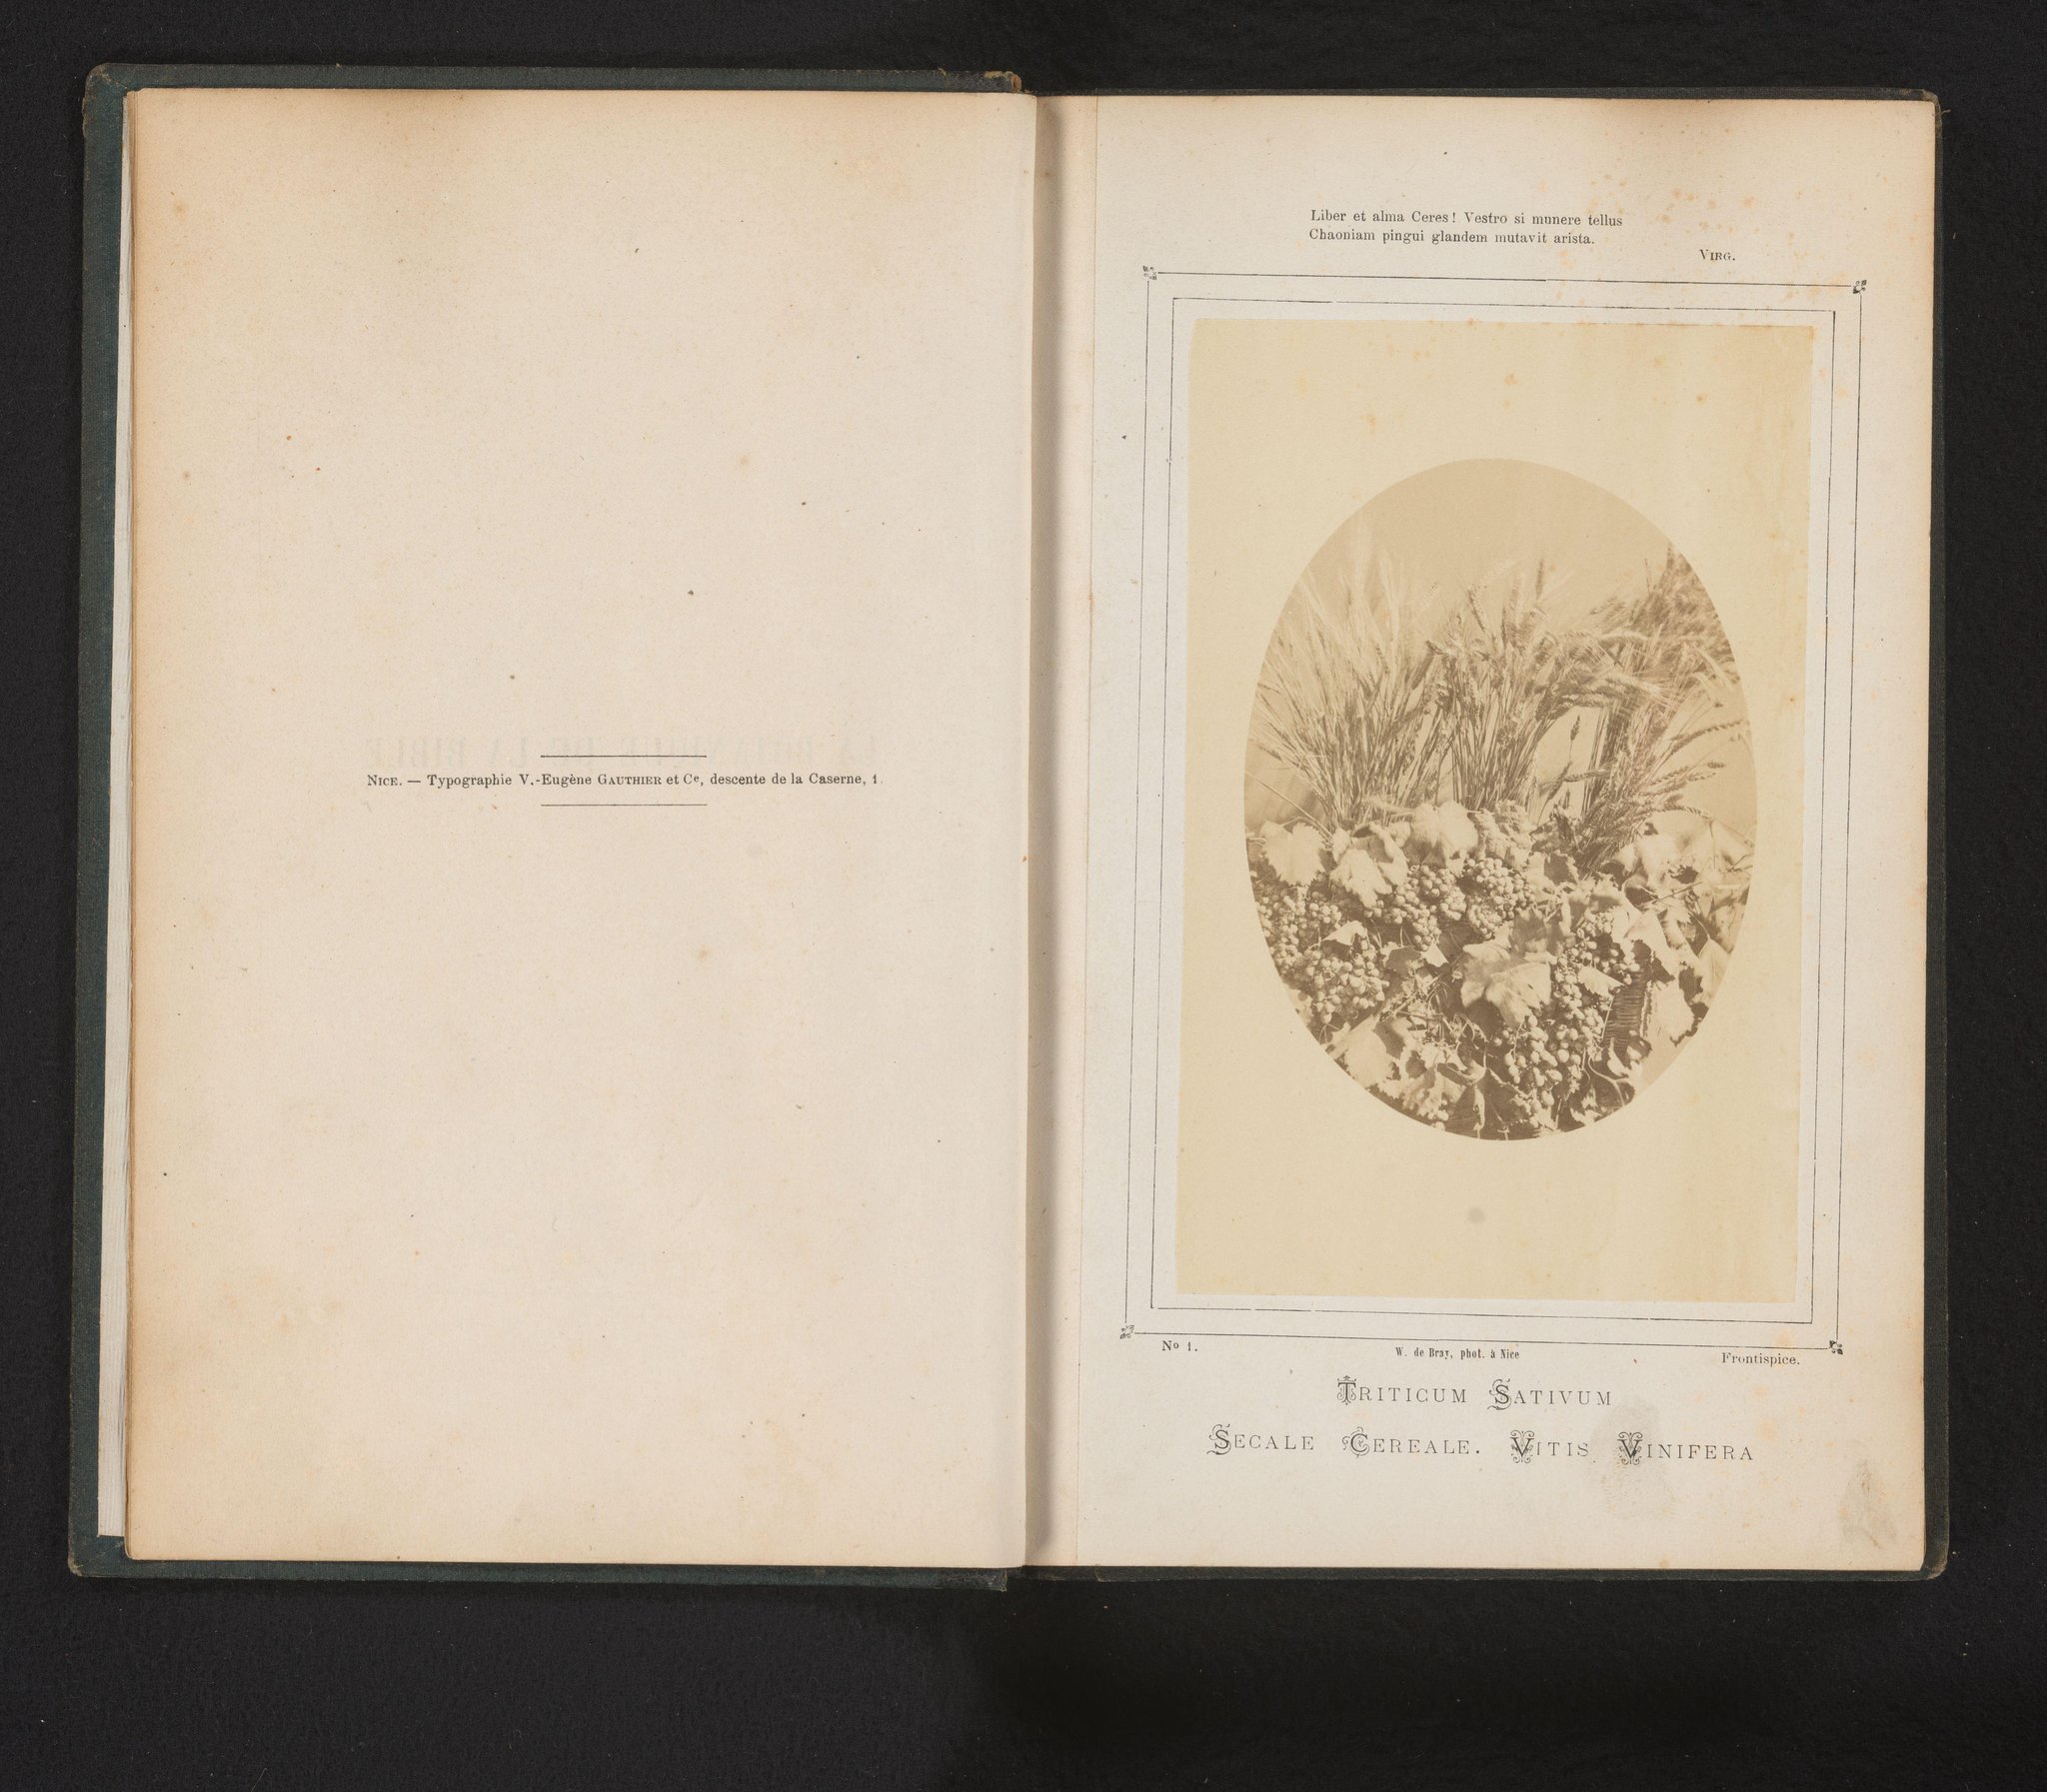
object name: photograph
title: Tarweplant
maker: jean walburg de bray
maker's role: fotograaf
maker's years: 1839-1901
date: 1866-1871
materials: paper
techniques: albumen print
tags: cereal, grain, corn (grass with grains, grown for food, e.g.: wheat, rice, rye, oats, maize, buckwheat, millet)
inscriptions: inscription: ‘Frontispice.’, number: ‘No. 1.’, inscription: ‘Liber et alma Ceres! Vestro si munere tellus/ Chaoniam pingui glandem mutavit arista./ VIRS.’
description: Foto op tweede ongenummerde pagina voor titelpagina.